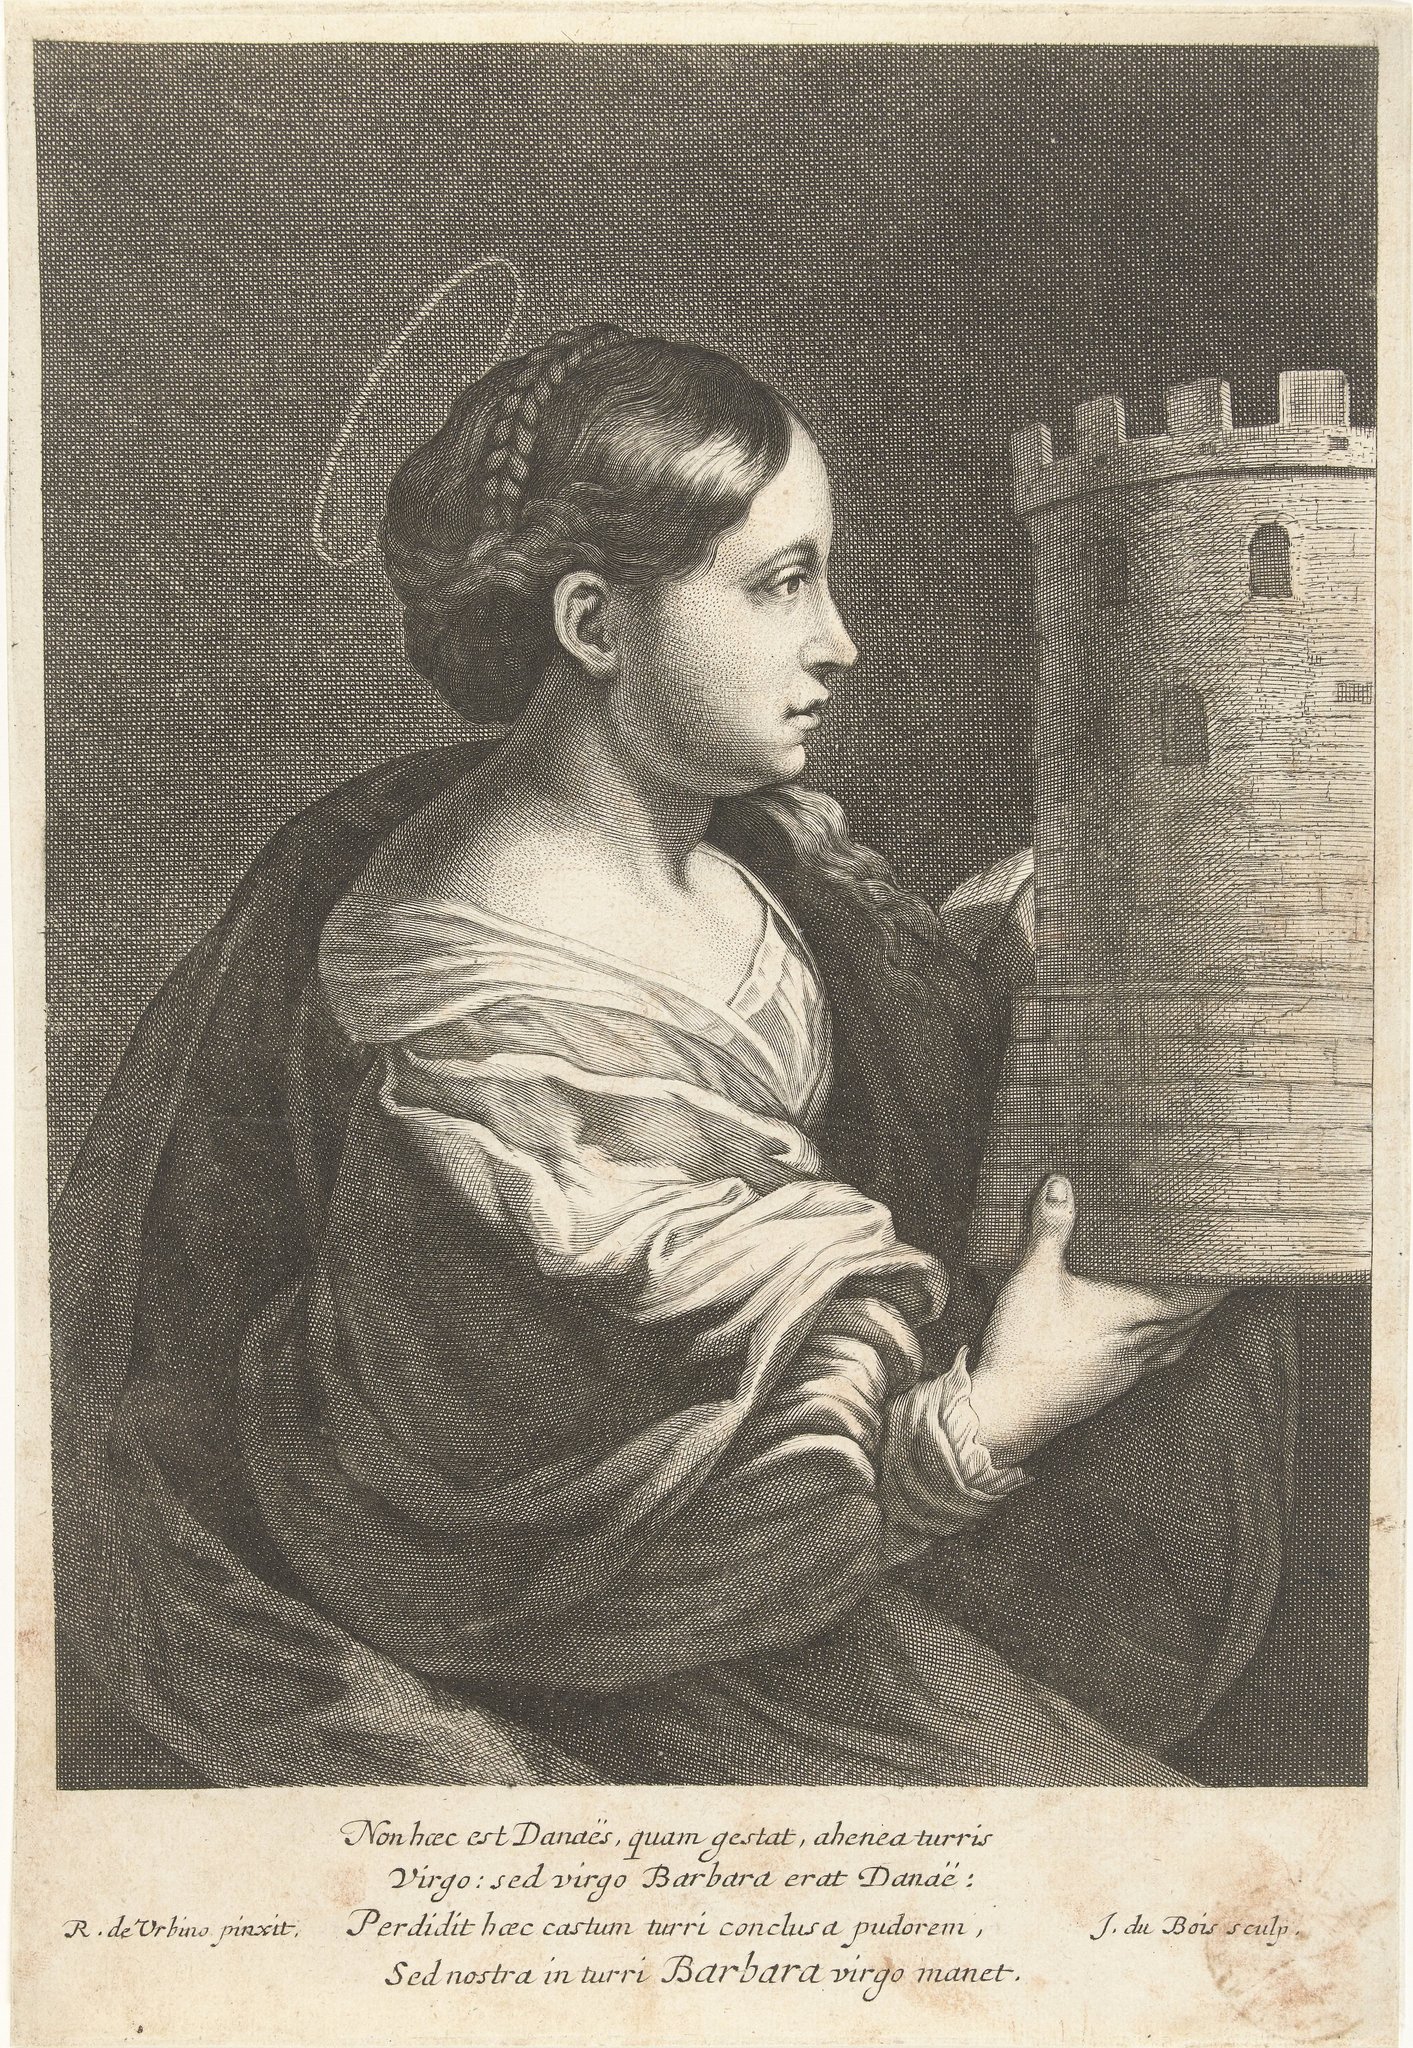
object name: print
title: H. Barbara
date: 1645-1655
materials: paper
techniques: engraving, etching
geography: amsterdam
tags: the virgin martyr barbara; possible attributes: book, cannon(ball), crown, cross, chalice with wafer, dioscuros (her father), peacock feather, sword, torches, mason's tools, tower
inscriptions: collector's mark: Lugt 240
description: De heilige Barbara met de toren, de plaats van haar gevangenschap, in haar handen. Barbara's haar ligt gevlochten om haar hoofd en ze heeft een aureool. Onder de voorstelling een Latijns vers op het leven van Barbara.